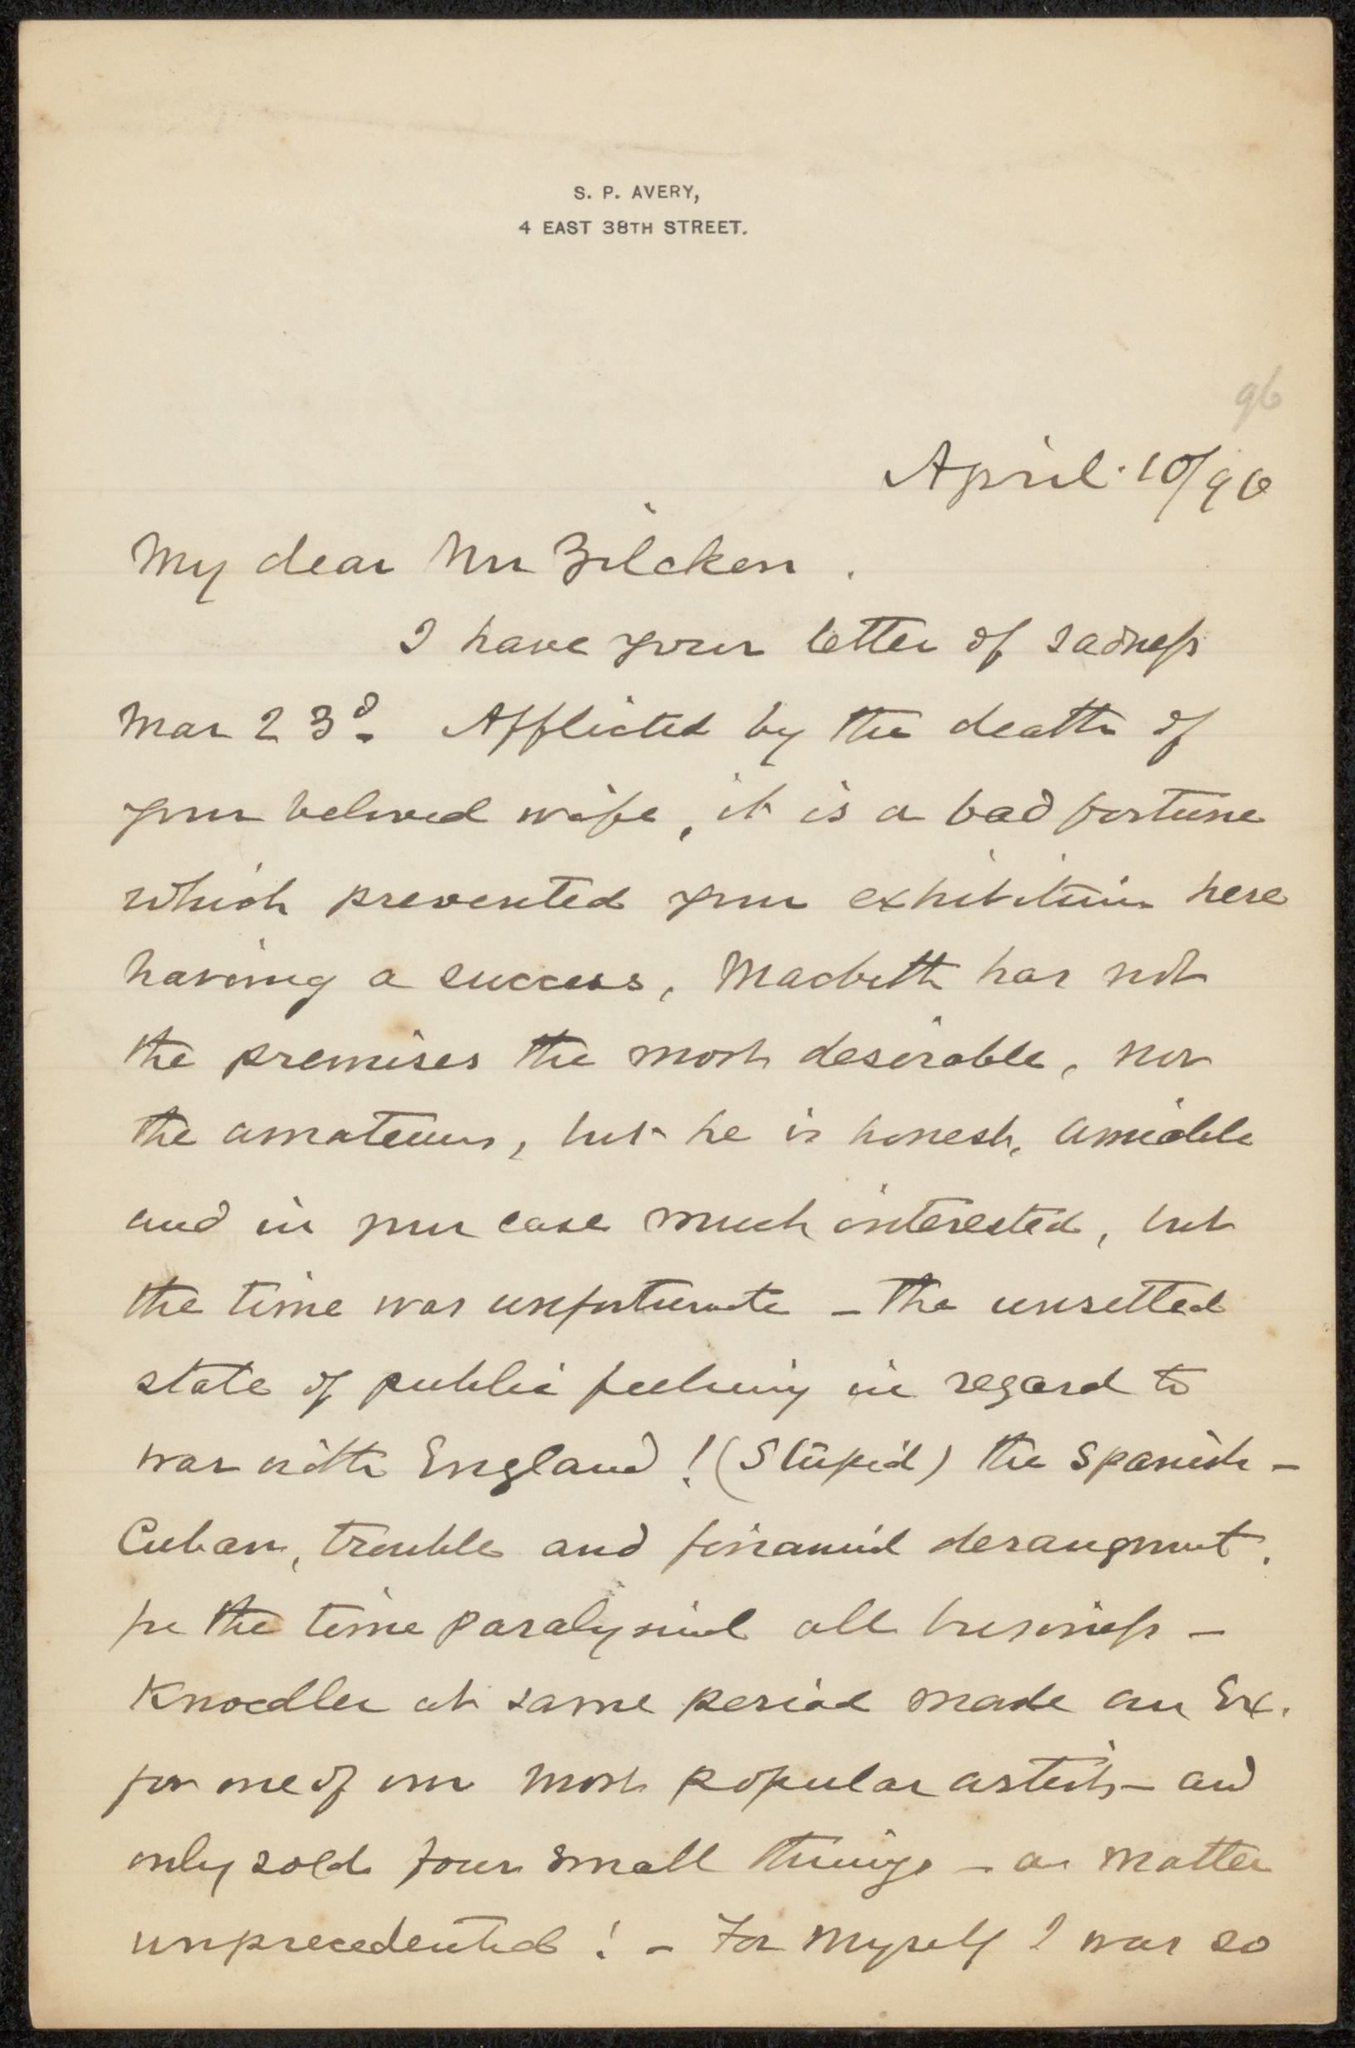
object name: letter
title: Brief aan Philip Zilcken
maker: samuel putnam avery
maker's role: verzamelaar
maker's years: 1822-1904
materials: ink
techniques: pen, printing, writing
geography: new york city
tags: william macbeth, the hague, painter, draughtsman, philip zilcken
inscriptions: collector's mark: ‘RPK’